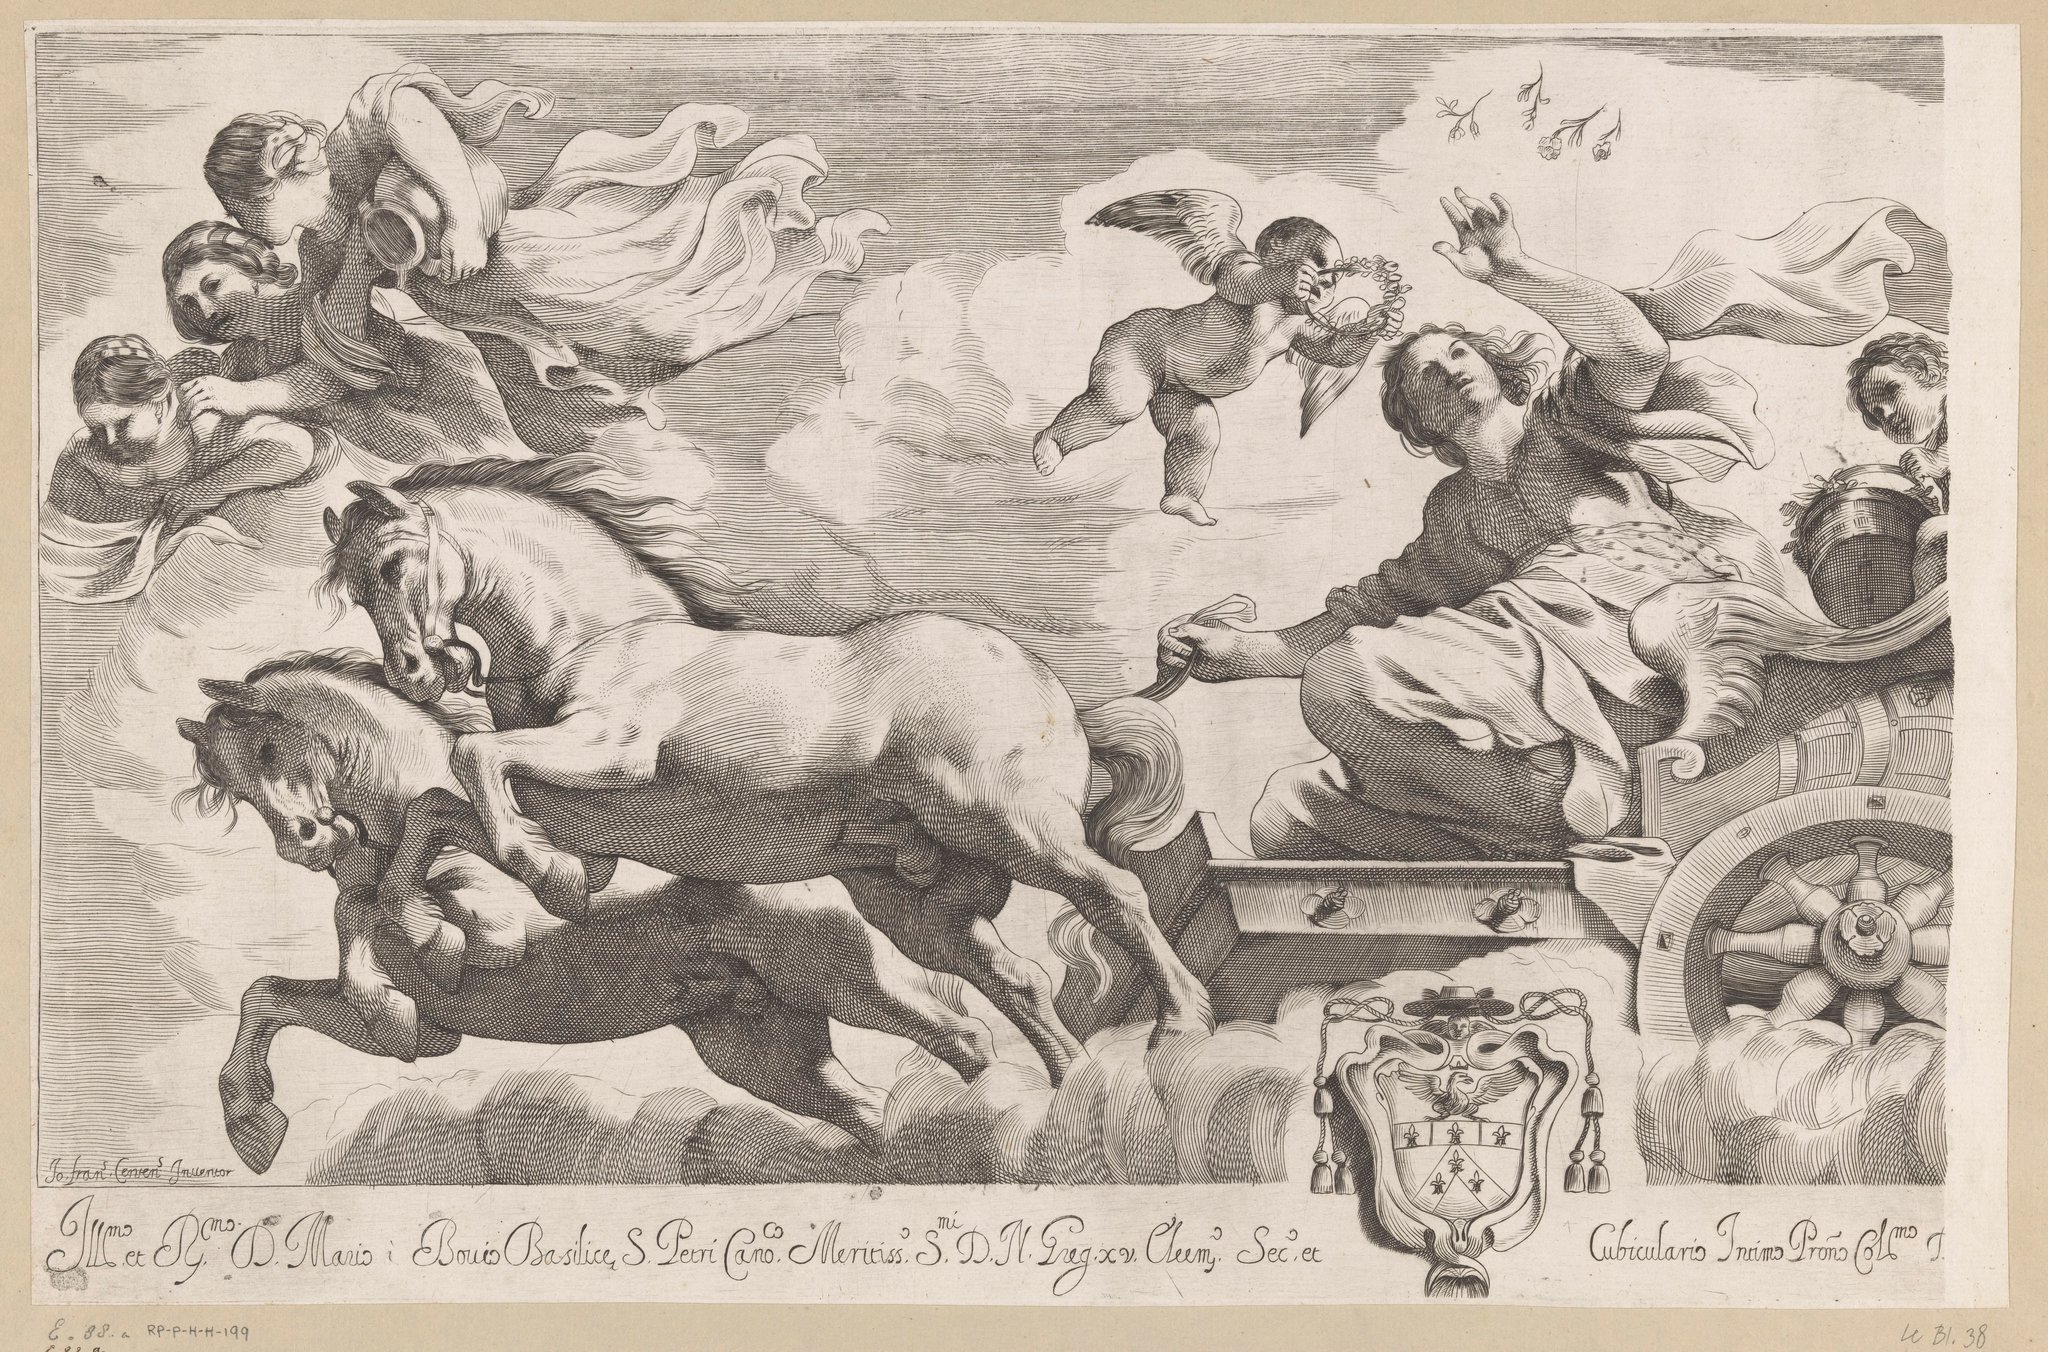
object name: print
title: Aurora verjaagt de nacht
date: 1621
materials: paper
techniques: engraving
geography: rome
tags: triumph of aurora: in her chariot drawn by two (sometimes four) horses, and possibly scattering flowers; aurora's victory over the night; 'carro dell'aurora' (ripa), hours (horae), seasons, armorial bearing, heraldry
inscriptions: collector's mark: Lugt 10, collector's mark: Lugt 11, number: ‘2’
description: Strooiend met bloemen rijdt Aurora op haar wagen die wordt getrokken door twee paarden. Iedere morgen verjaagt Aurora de nacht en brengt zij het ochtendgloren. Voor haar uit zweven de horae, de godinnen van de jaargetijden. Rechts kijkt Aurora's echtgenoot Tithonus haar na. Opdracht in de ondermarge en middenonder een wapenschild.